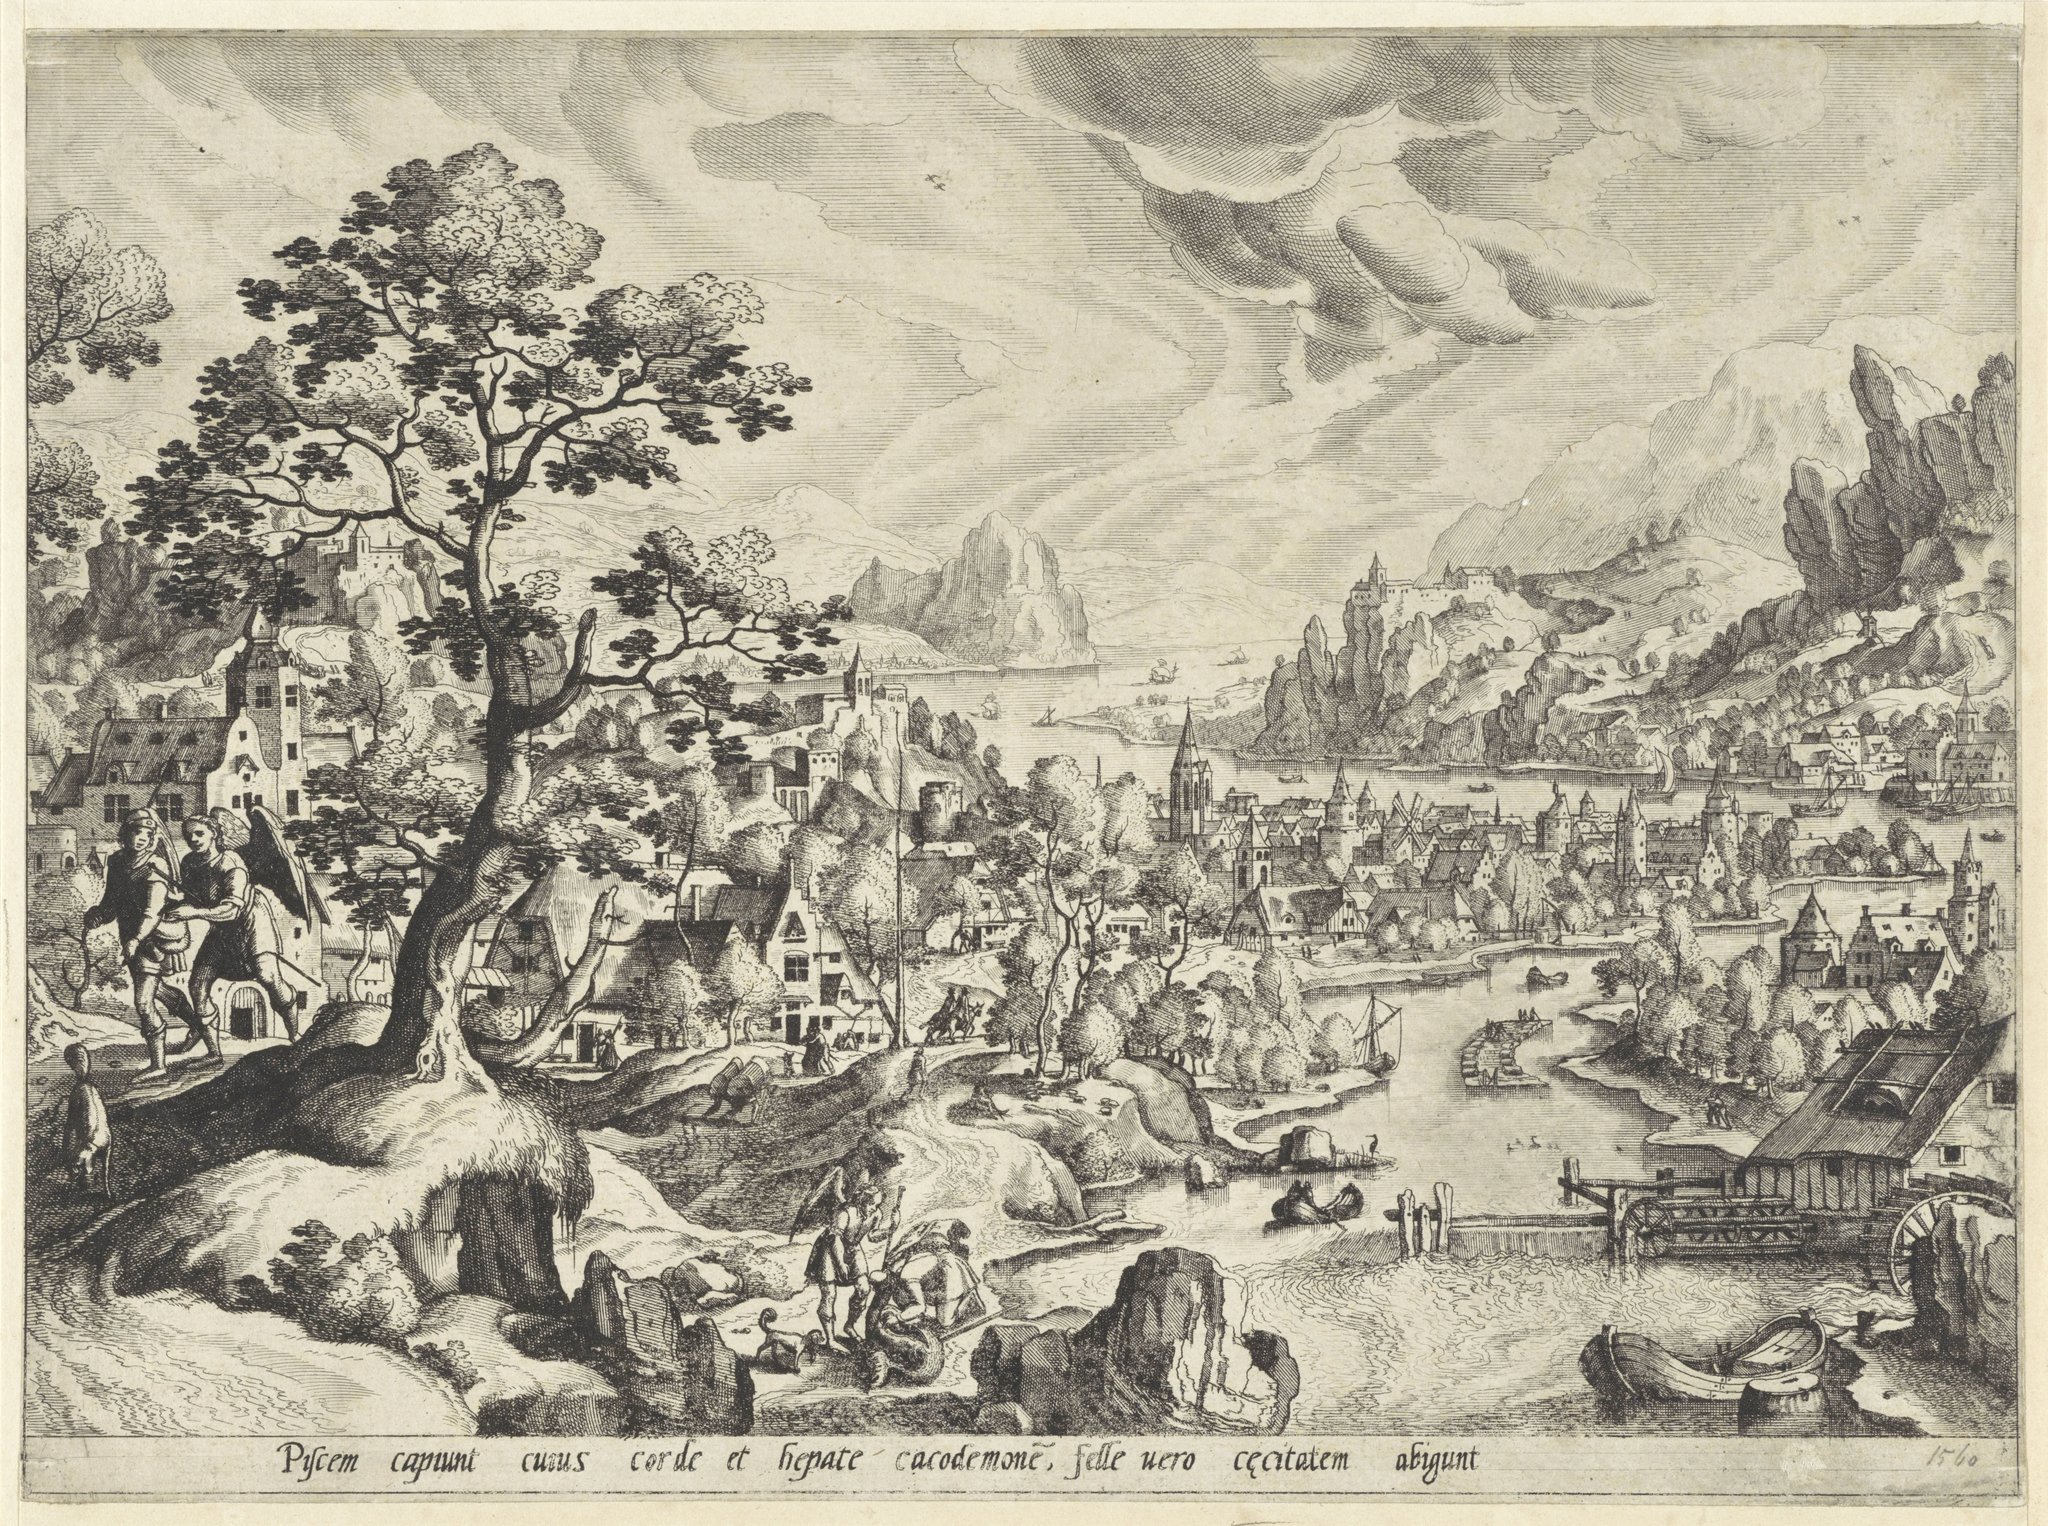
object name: print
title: Tobias snijdt de vis open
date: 1547-1591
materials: paper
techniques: etching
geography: low countries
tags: tobias cuts up the fish and removes the heart, liver and gall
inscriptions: collector's mark: Lugt 2228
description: Aan de bebouwde oever van een rivier geeft aartsengel Rafaël Tobias de opdracht om de zojuist door hem gevangen vis open te snijden om het hart, de lever en de gal eruit te halen. Linksvoor lopen Tobias en Rafaël over een pad. Tobias' hond vergezelt hen. Onderaan in de marge een verklarende, éénregelige tekst in het Latijn.